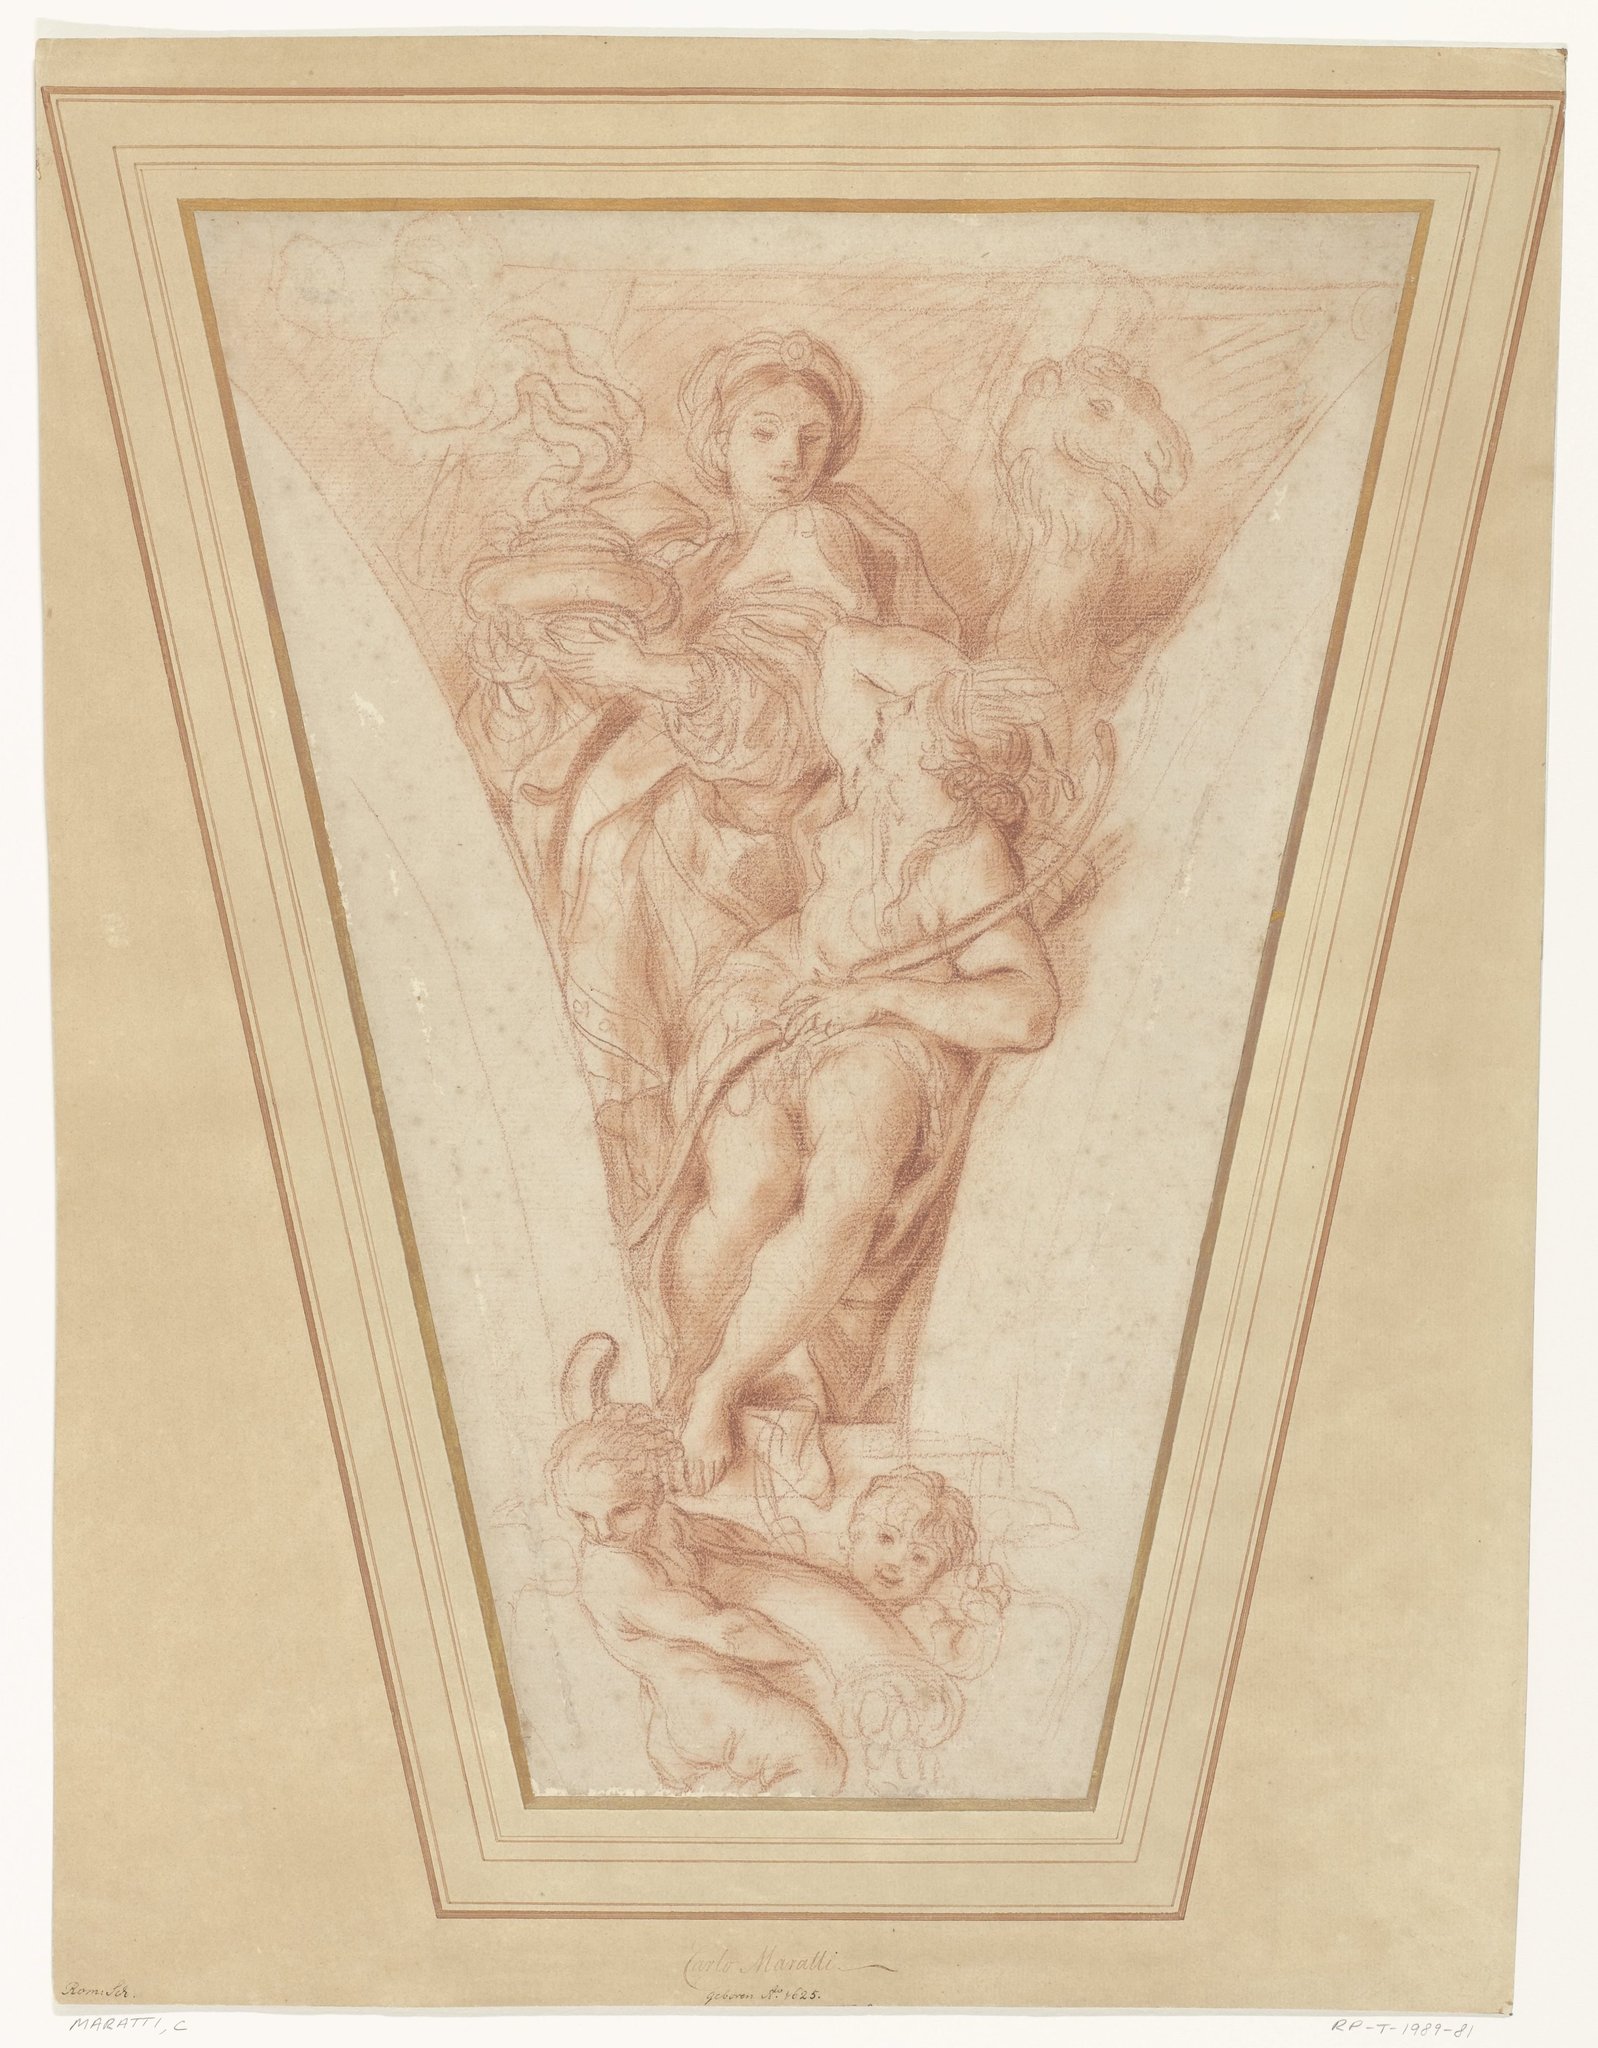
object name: drawing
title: The Continents of Asia and America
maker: carlo maratta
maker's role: draughtsman, painter, print maker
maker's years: 1625-1713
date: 1674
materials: chalk, paper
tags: asia represented allegorically; 'asia' (ripa), america represented allegorically; 'america' (ripa)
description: Maratti compressed the two female figures representing Asia and America and their attributes together in an awkward, triangular space with considerable virtuosity. Initially the idea was that each corner of the sala grande in Palazzo Altieri in Rome would represent one continent – standing for the omnipotence of the patron Pope Clement x. But because only three spandrels were available, the decorative programme – which was never realized – had to be modified.